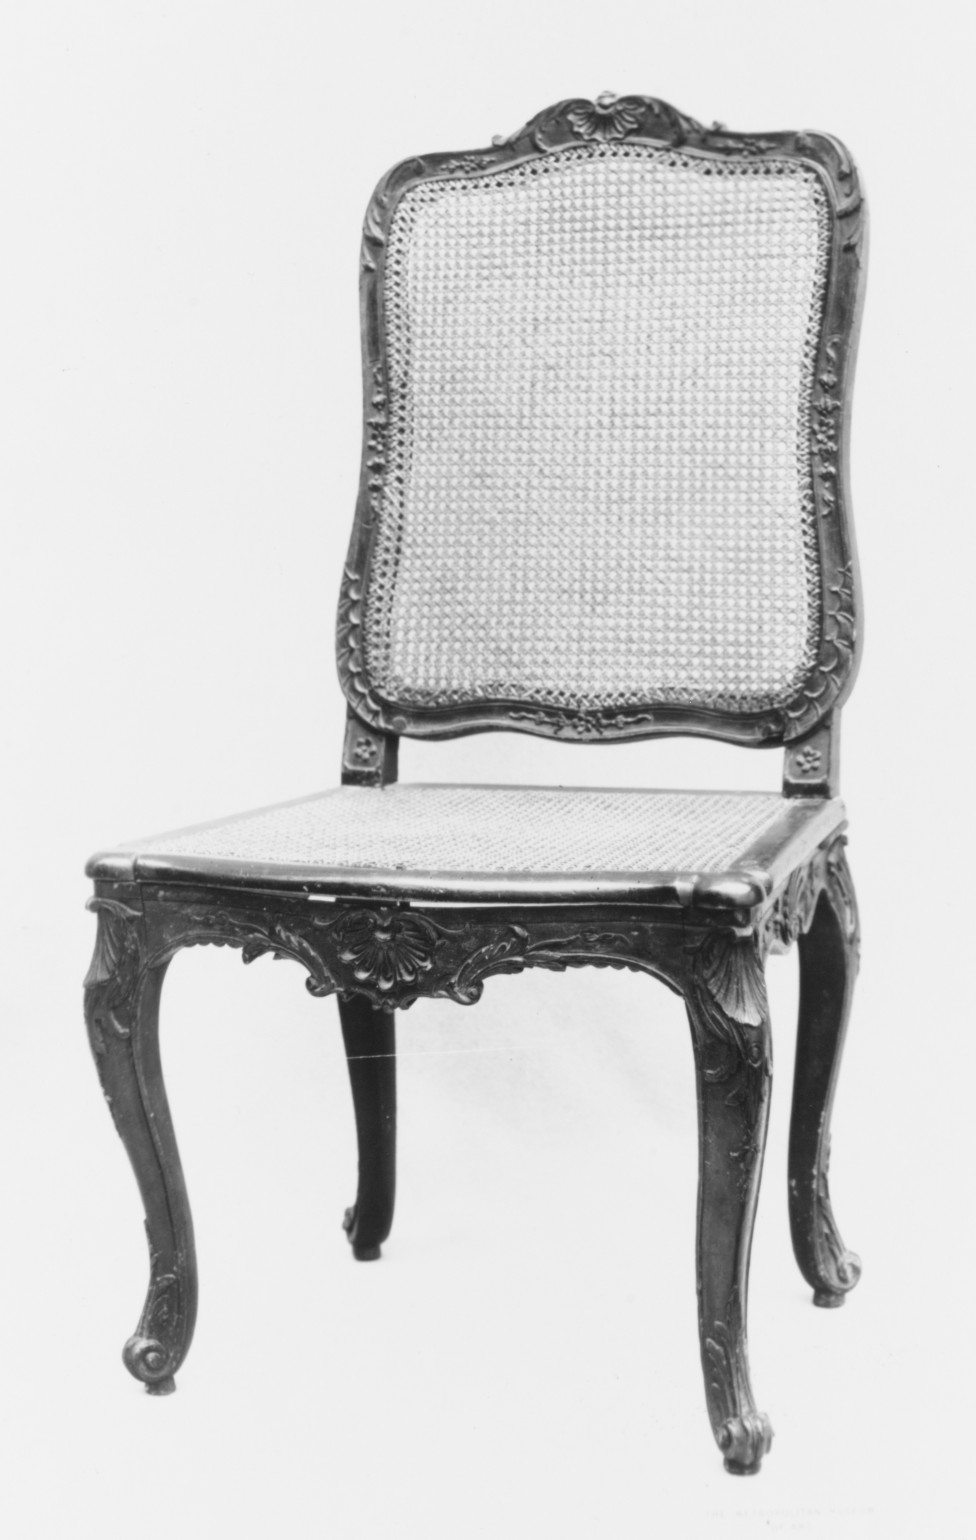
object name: side chair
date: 1701-1725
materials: wood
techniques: carving